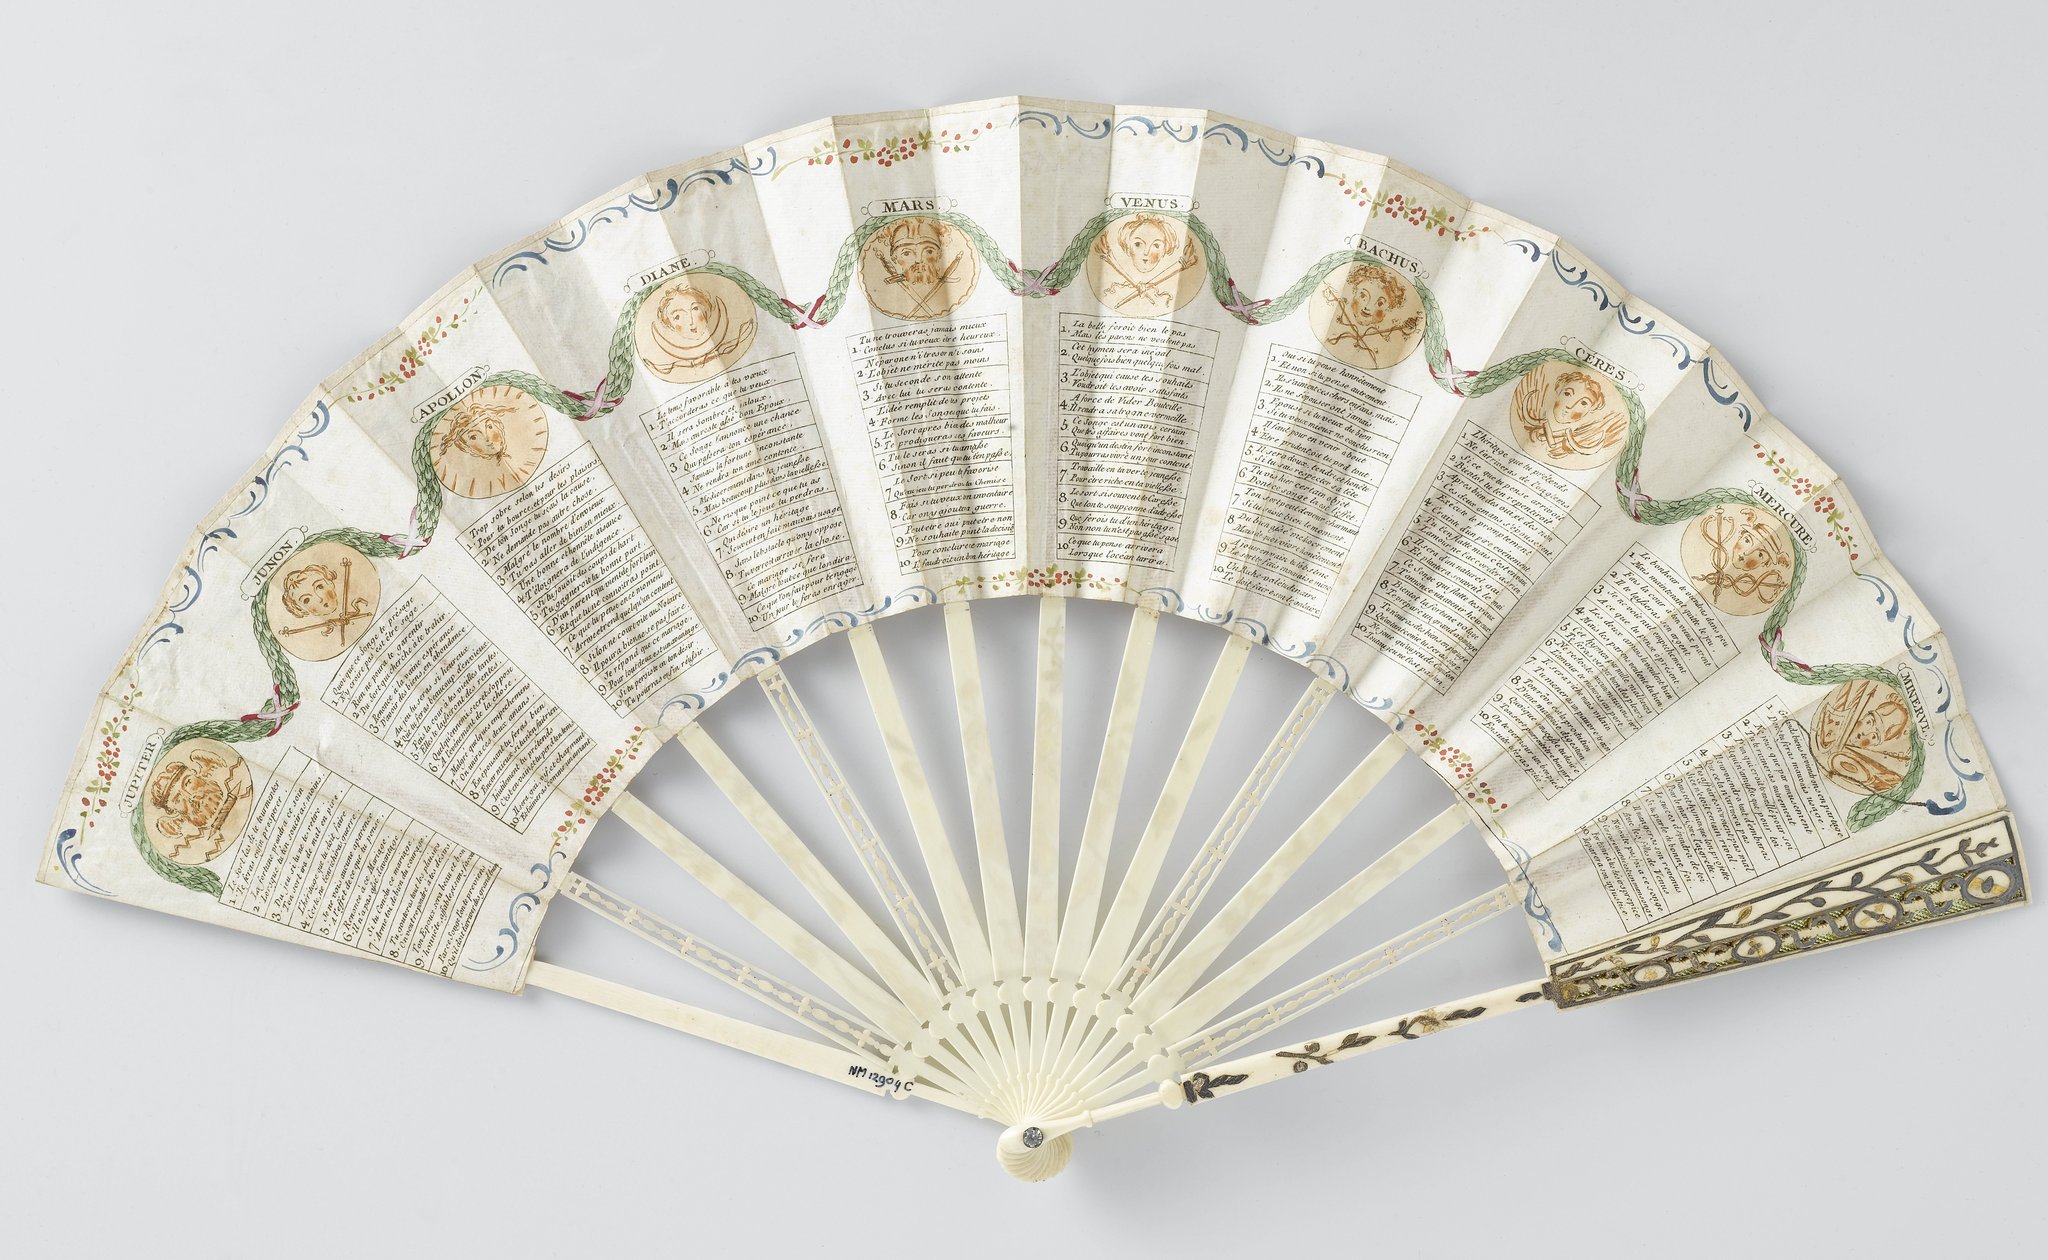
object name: vouwwaaier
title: Vouwwaaier met twee papieren bladen, waarop het vraag- en antwoordspel "l'Oracle" is gedrukt en ingekleurd, op een gesneden ivoren montuur voorzien van 'métal en quattre couleurs'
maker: Anonymous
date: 1780-1790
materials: paint, glass, gold leaf, ivory, paper, ink, silver leaf, watercolor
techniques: cutting, grinding, printing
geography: france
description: Vouwwaaier met twee papieren bladen waarop het vraag en antwoordspel l'Oracle is gedrukt en ingekleurd, op een gesneden ivoren montuur voorzien van 'métal en quattre couleurs'. 15 niet aaneengesloten ajour bewerkte benen. De papieren bladen zijn bedrukt en beschilderd. Op de voorzijde staat een geluksrad en twee putti, die het opschrift l'Oracle vasthouden, centraal met aan weerszijden waarzeggerstabellen waaronder vragen in een cartouche. Op de achterzijde staan tien kolommen met godennamen en hun attributen. Met het vraag en antwoordspel 'Oracle' kon de toekomst voorspeld worden. Hiervoor waren twee getallen nodig: allereerst moest men het nummer van de vraag kiezen. Het tweede getal werd verkregen door met een ivoren pijl, die met een koordje aan de waaier hing (ontbreekt hier), blind te prikken in het rad van fortuin midden op de waaier. Het tweede getal verwees naar de lijsten met goden links en rechts van het rad, terwijl het eerste nummer werd gebruikt om in de betreffende lijst de vereiste godheid te vinden. Dan werd de waaier omgedraaid en zocht men in de lijst van de juiste gevonden god naar het getal, dat door het prikken in het rad van fortuin was verkregen. Op deze manier vond men dan uiteindelijk het antwoord.